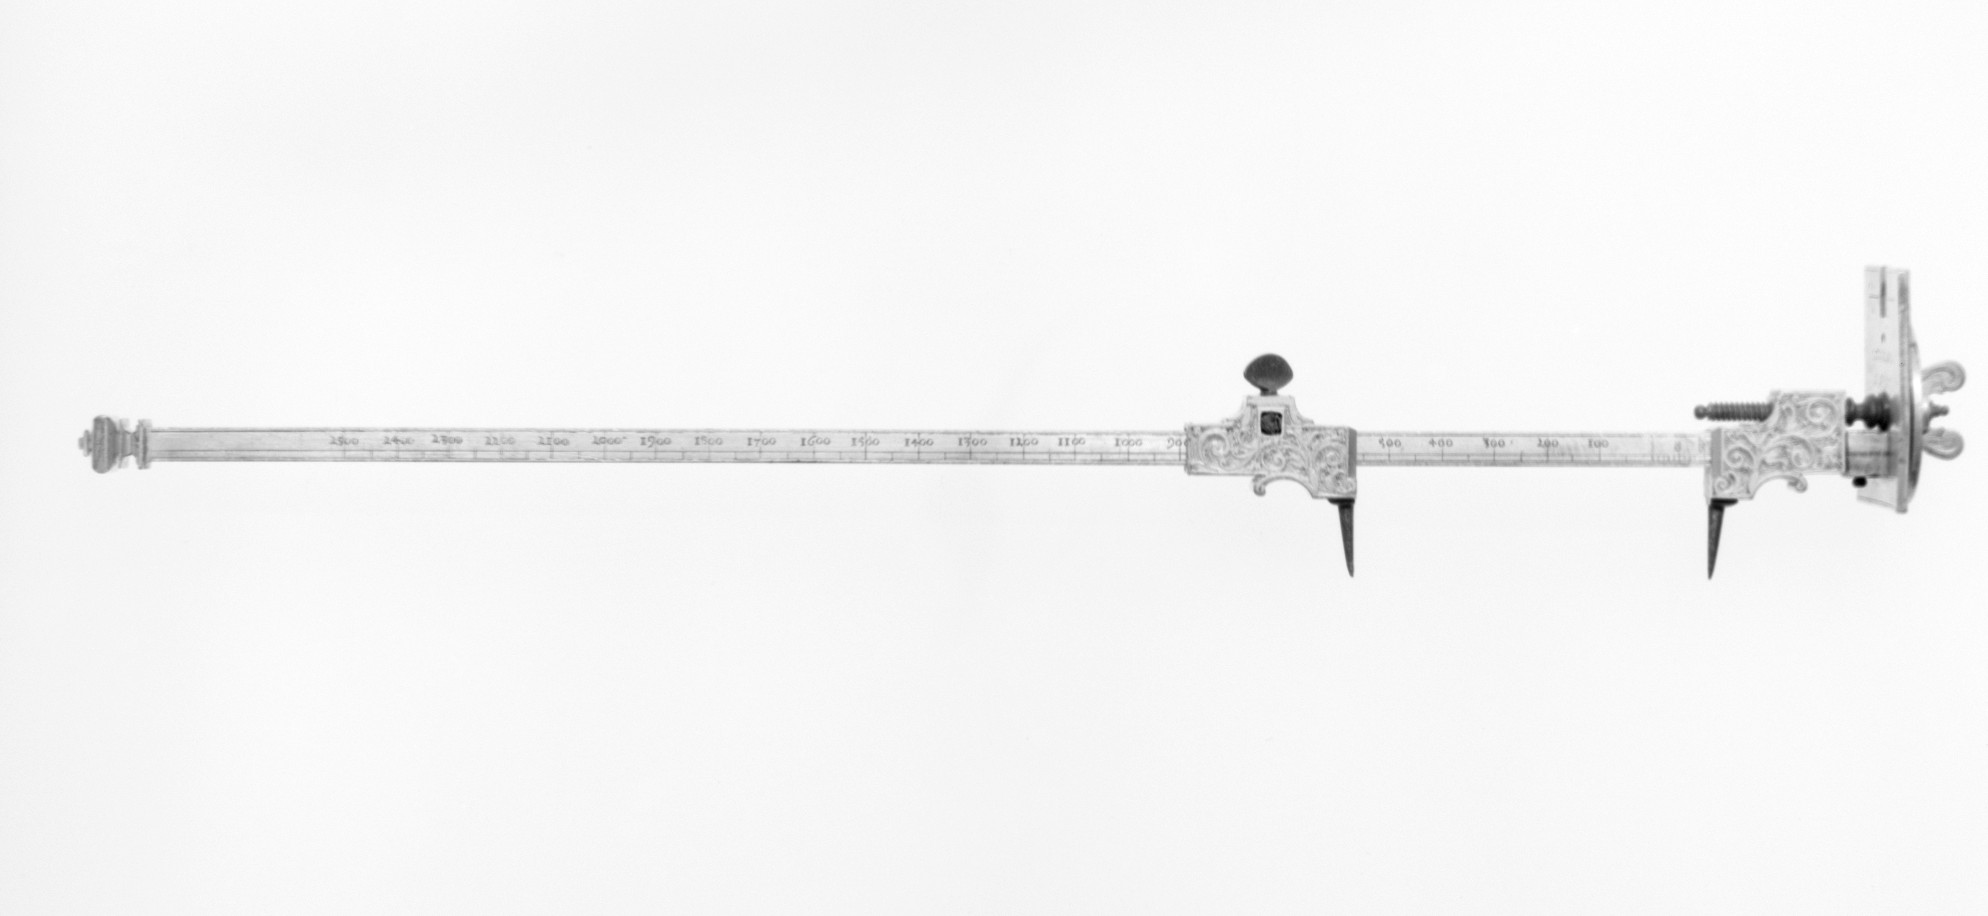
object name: beam compass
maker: christopher trechsler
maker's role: maker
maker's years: 1550-1624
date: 1619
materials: brass, gilt